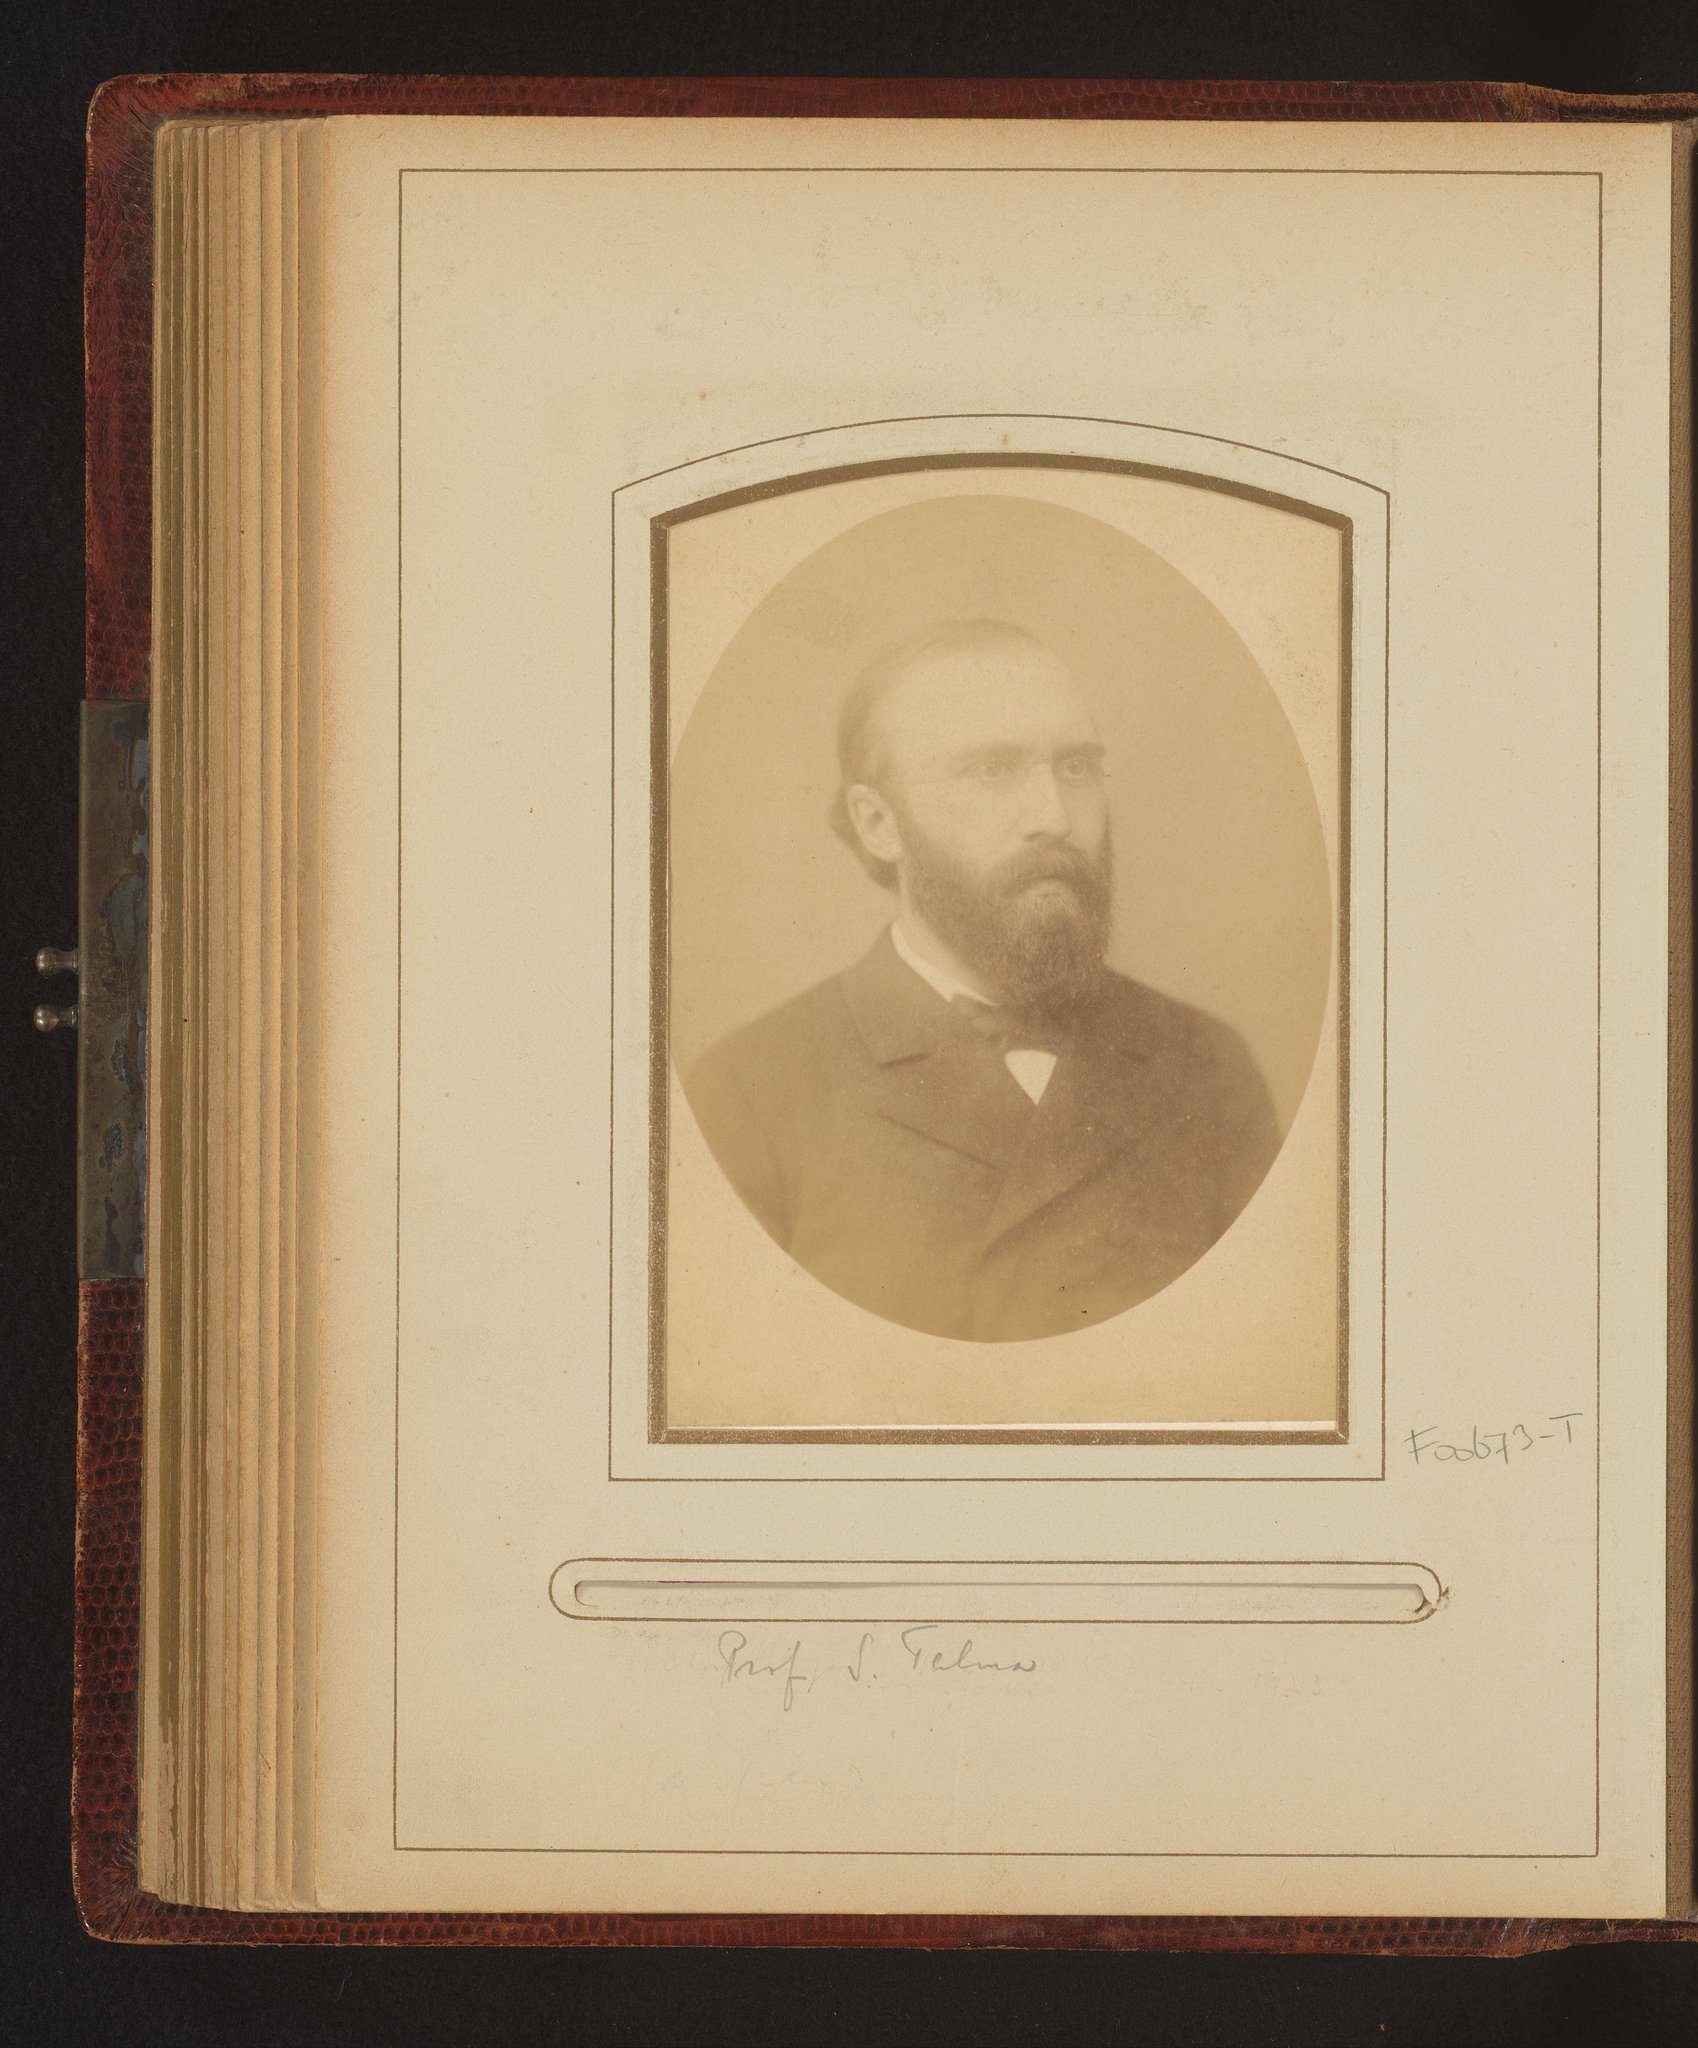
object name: cabinet photograph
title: Portret van Sape Talma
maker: Anonymous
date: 1876-1890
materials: cardboard, photographic support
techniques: albumen print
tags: utrecht, historical persons, professor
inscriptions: annotation: ‘Prof S. Talma’, annotation: ‘prof. Talma’